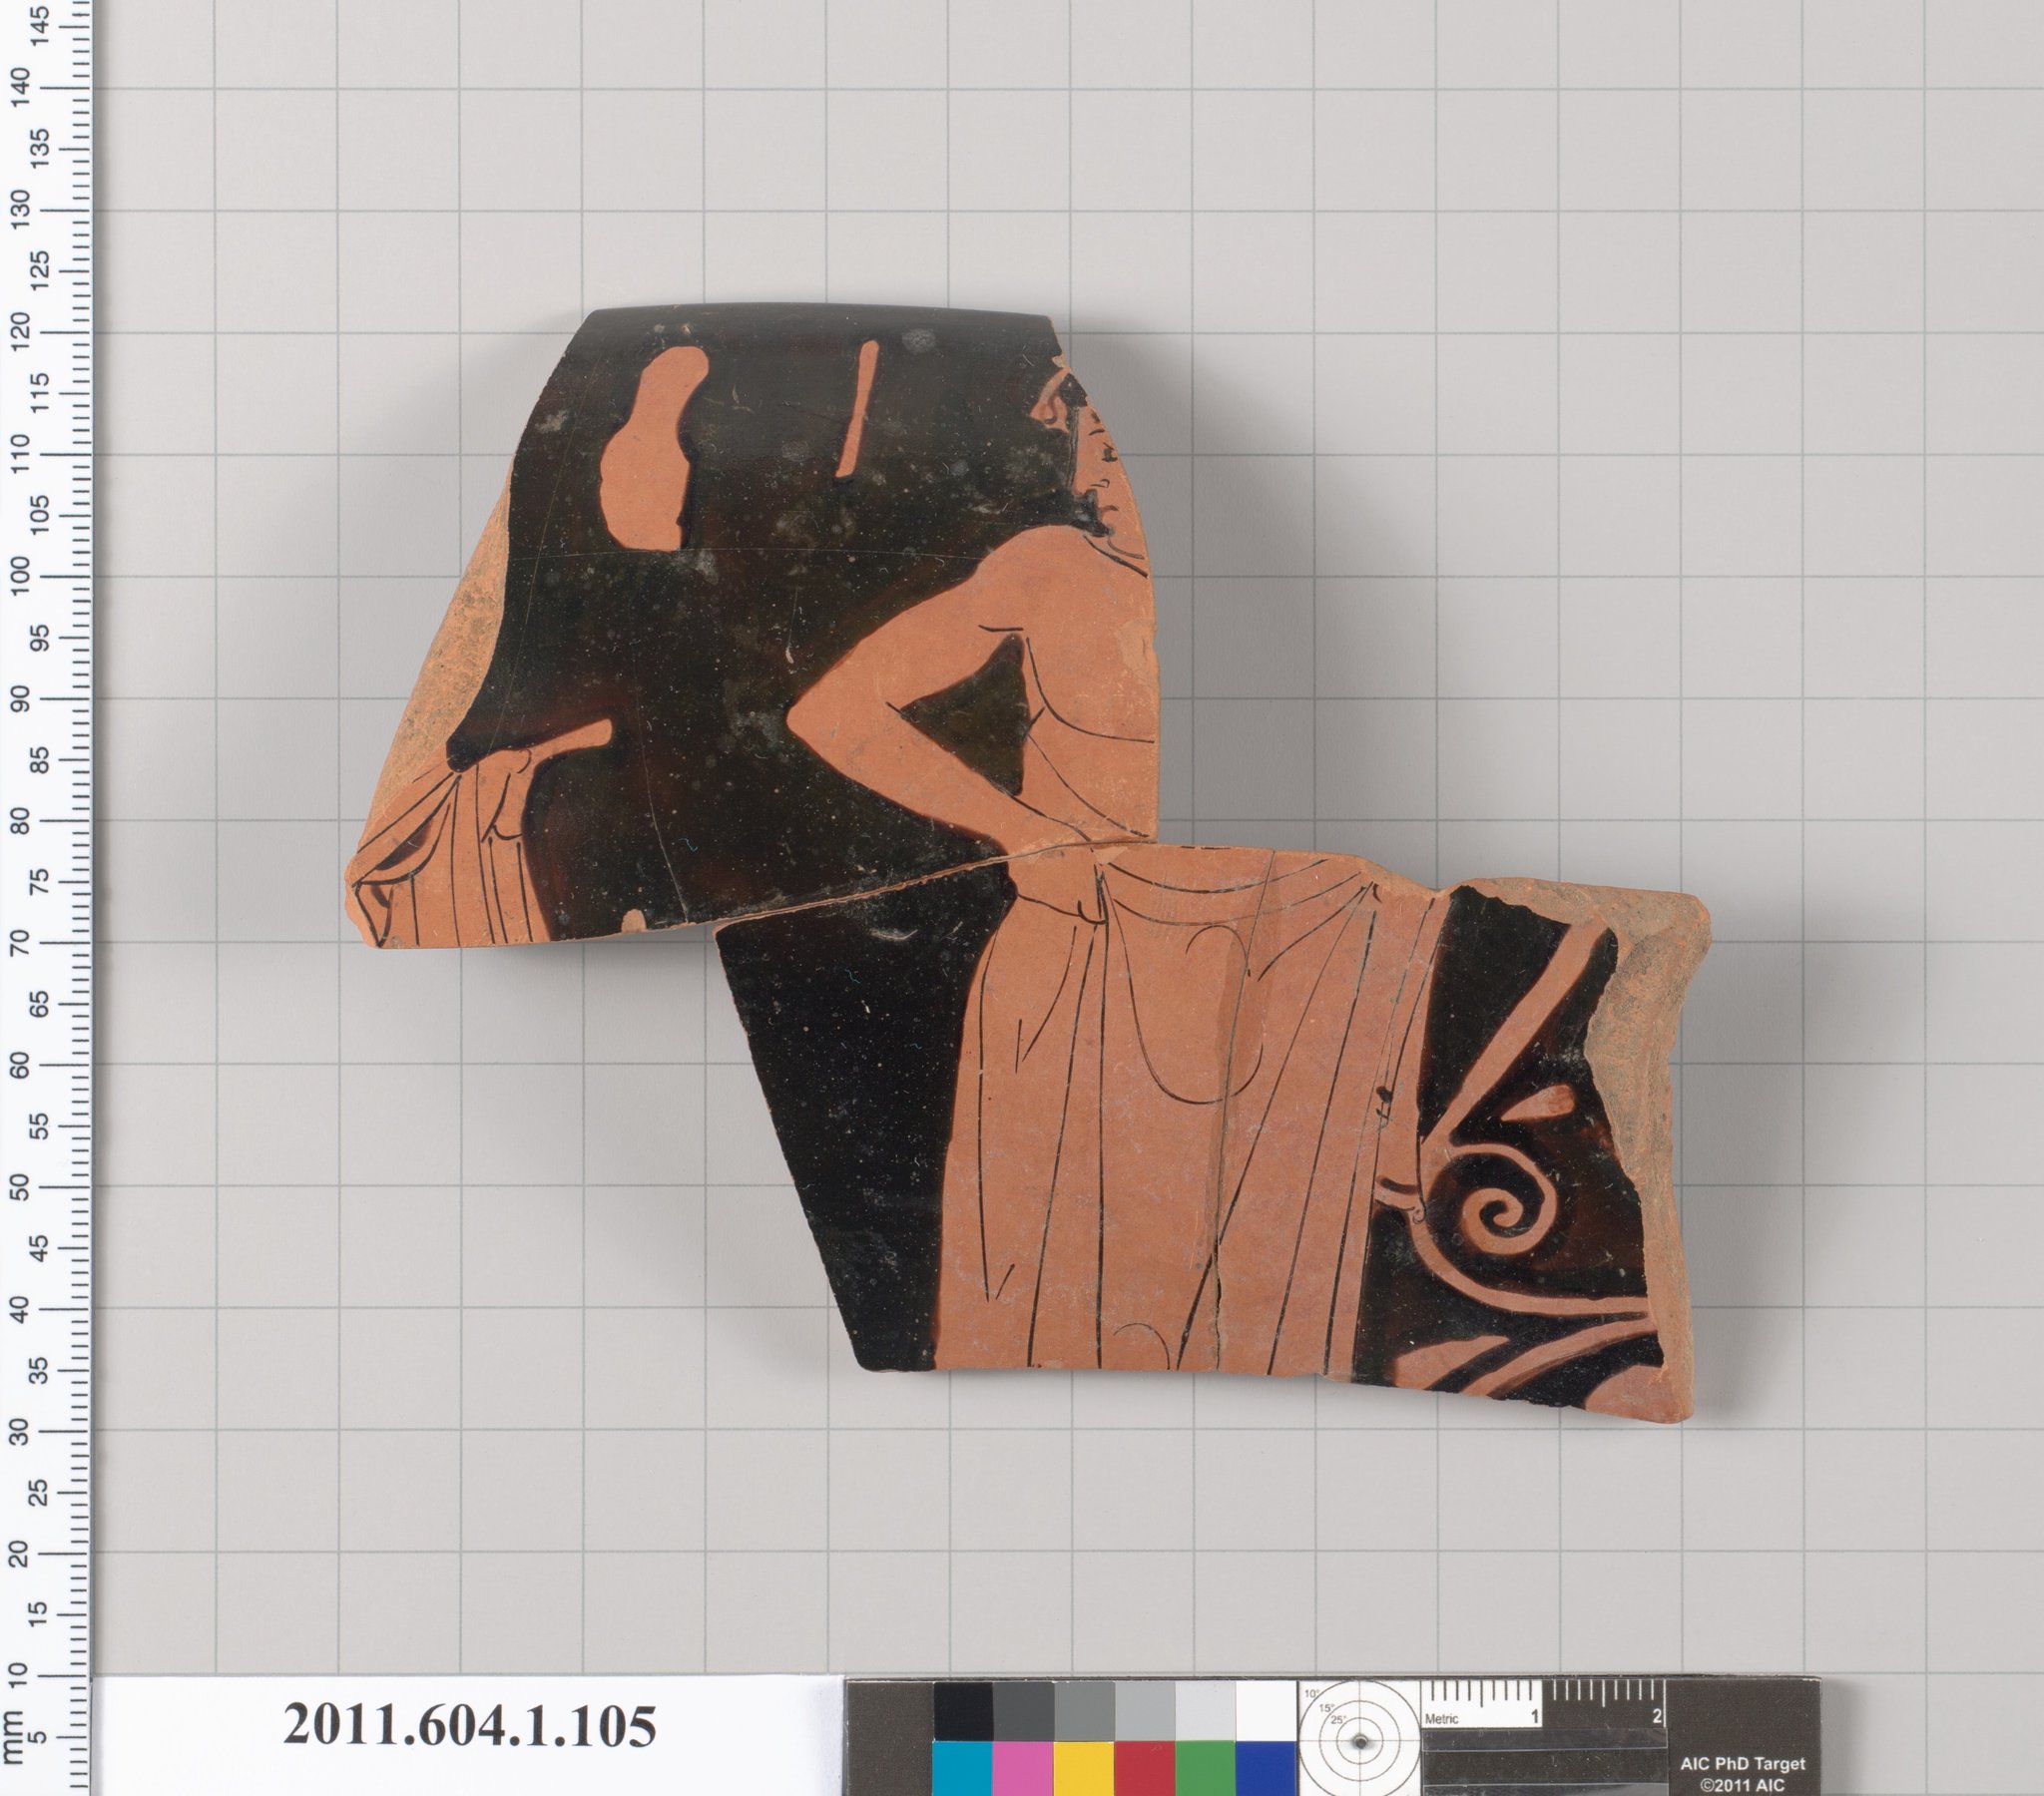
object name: kylix fragment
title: Terracotta fragment of a kylix (drinking cup)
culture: greek, attic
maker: splanchnopt painter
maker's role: artist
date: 470-450 BCE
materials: terracotta